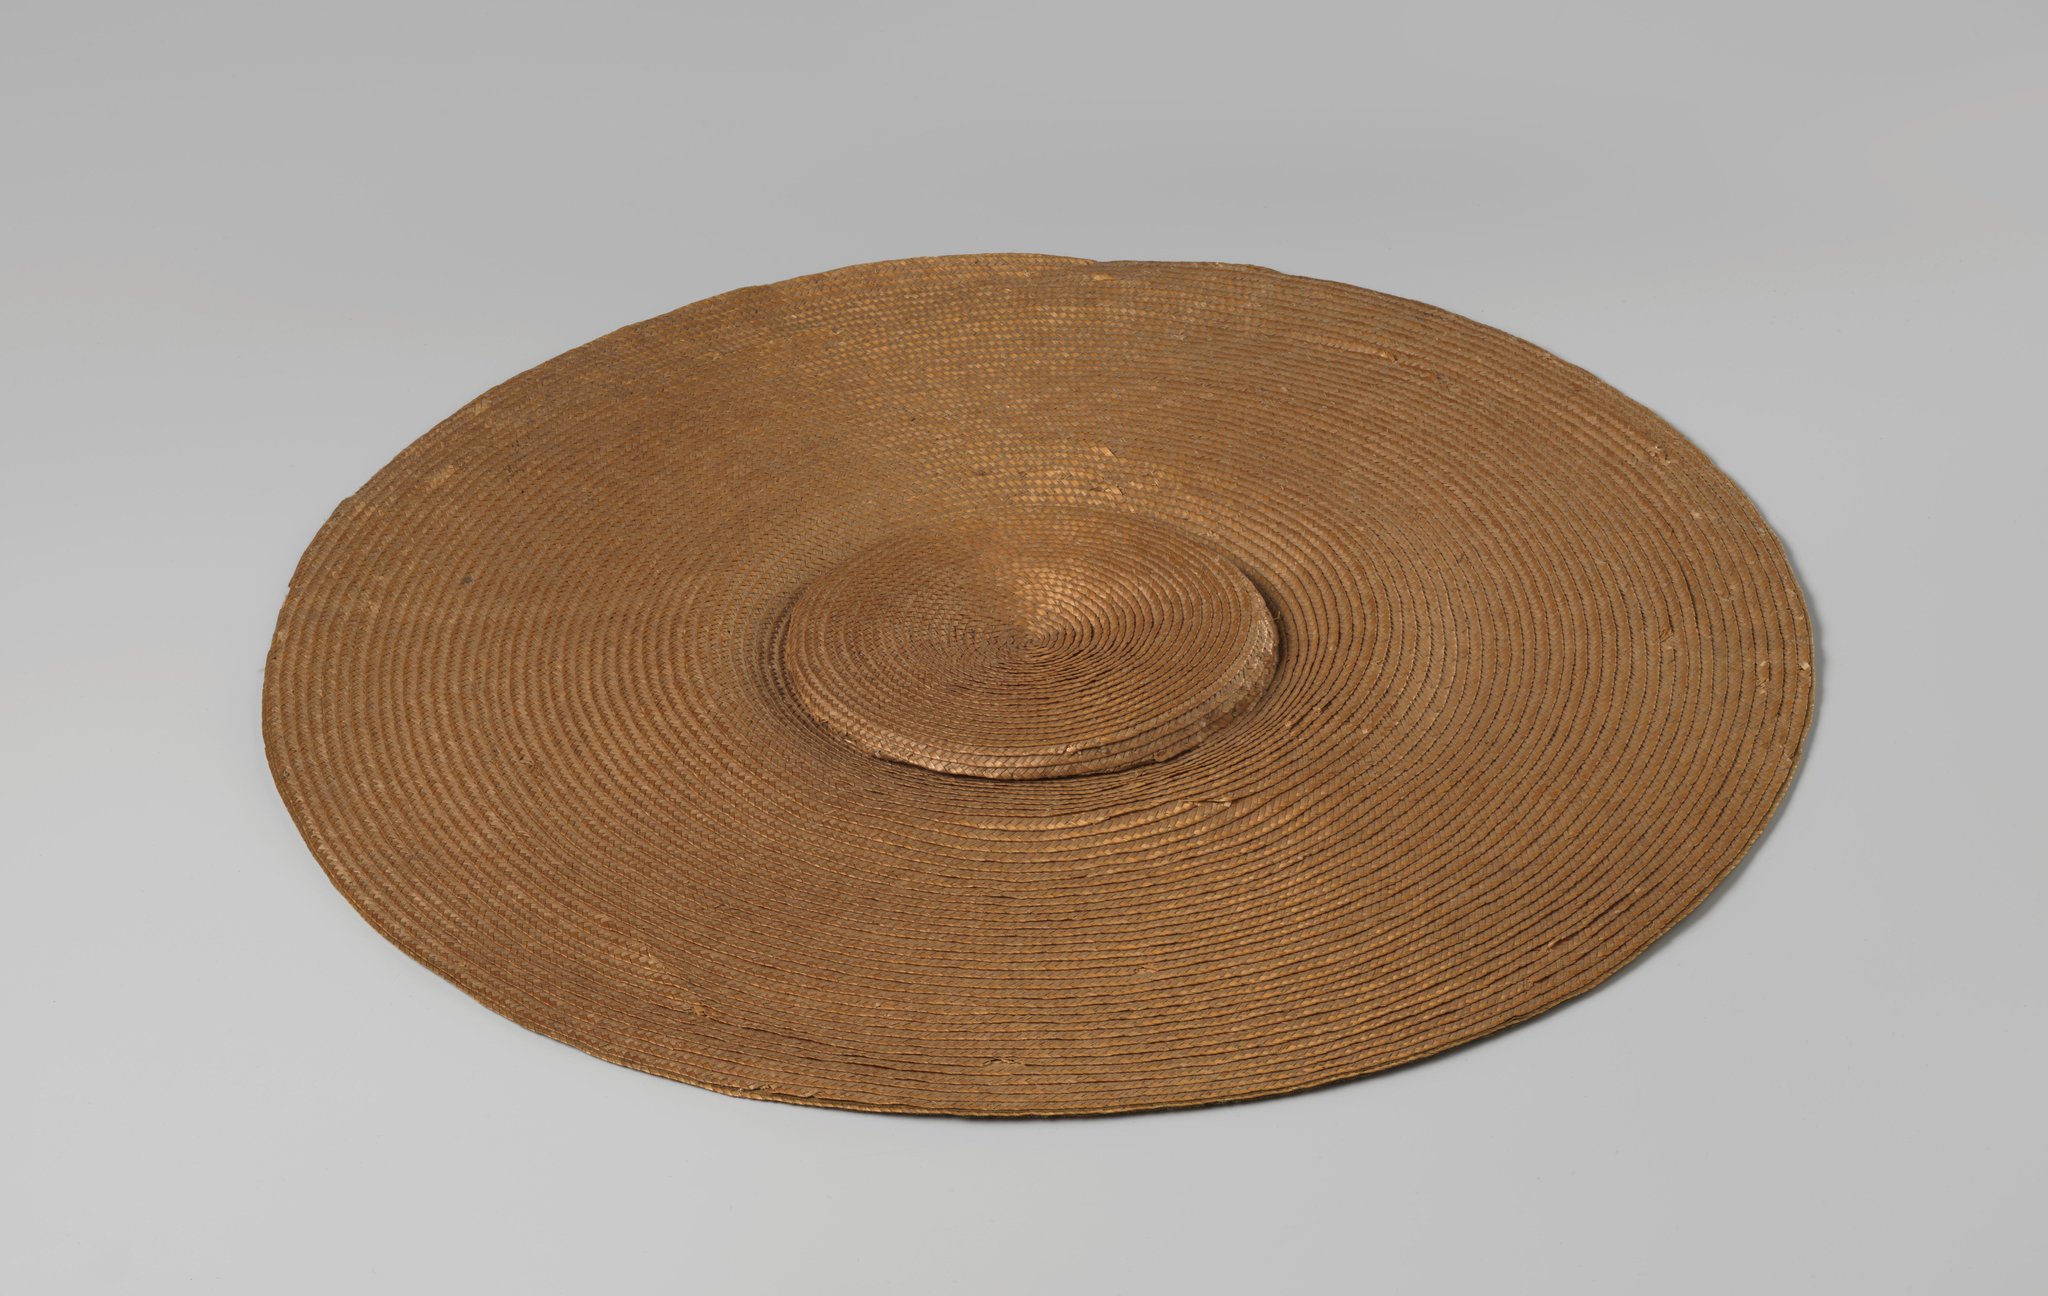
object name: zonnehoed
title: Zonnehoed, Walcherse dracht (?), van stro, gevoerd met sits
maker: Anonymous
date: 1735-1765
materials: textile, cotton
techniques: braiding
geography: netherlands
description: Zonnehoed, Walcherse dracht(?) of quasi landelijke mode van "herderin" of "snellemerige". Model: zeer platte bol en vlakke brede rand. Materiaal: naturel stroo, gevoerd met echte sits. Voering: de sits heeft een indigo blauwe onder grond, waarop een groot dekor van rode ranken en rode bloemen, als roos, anjer en tulp. De blauwgroene blaadjes zijn geelgerand.